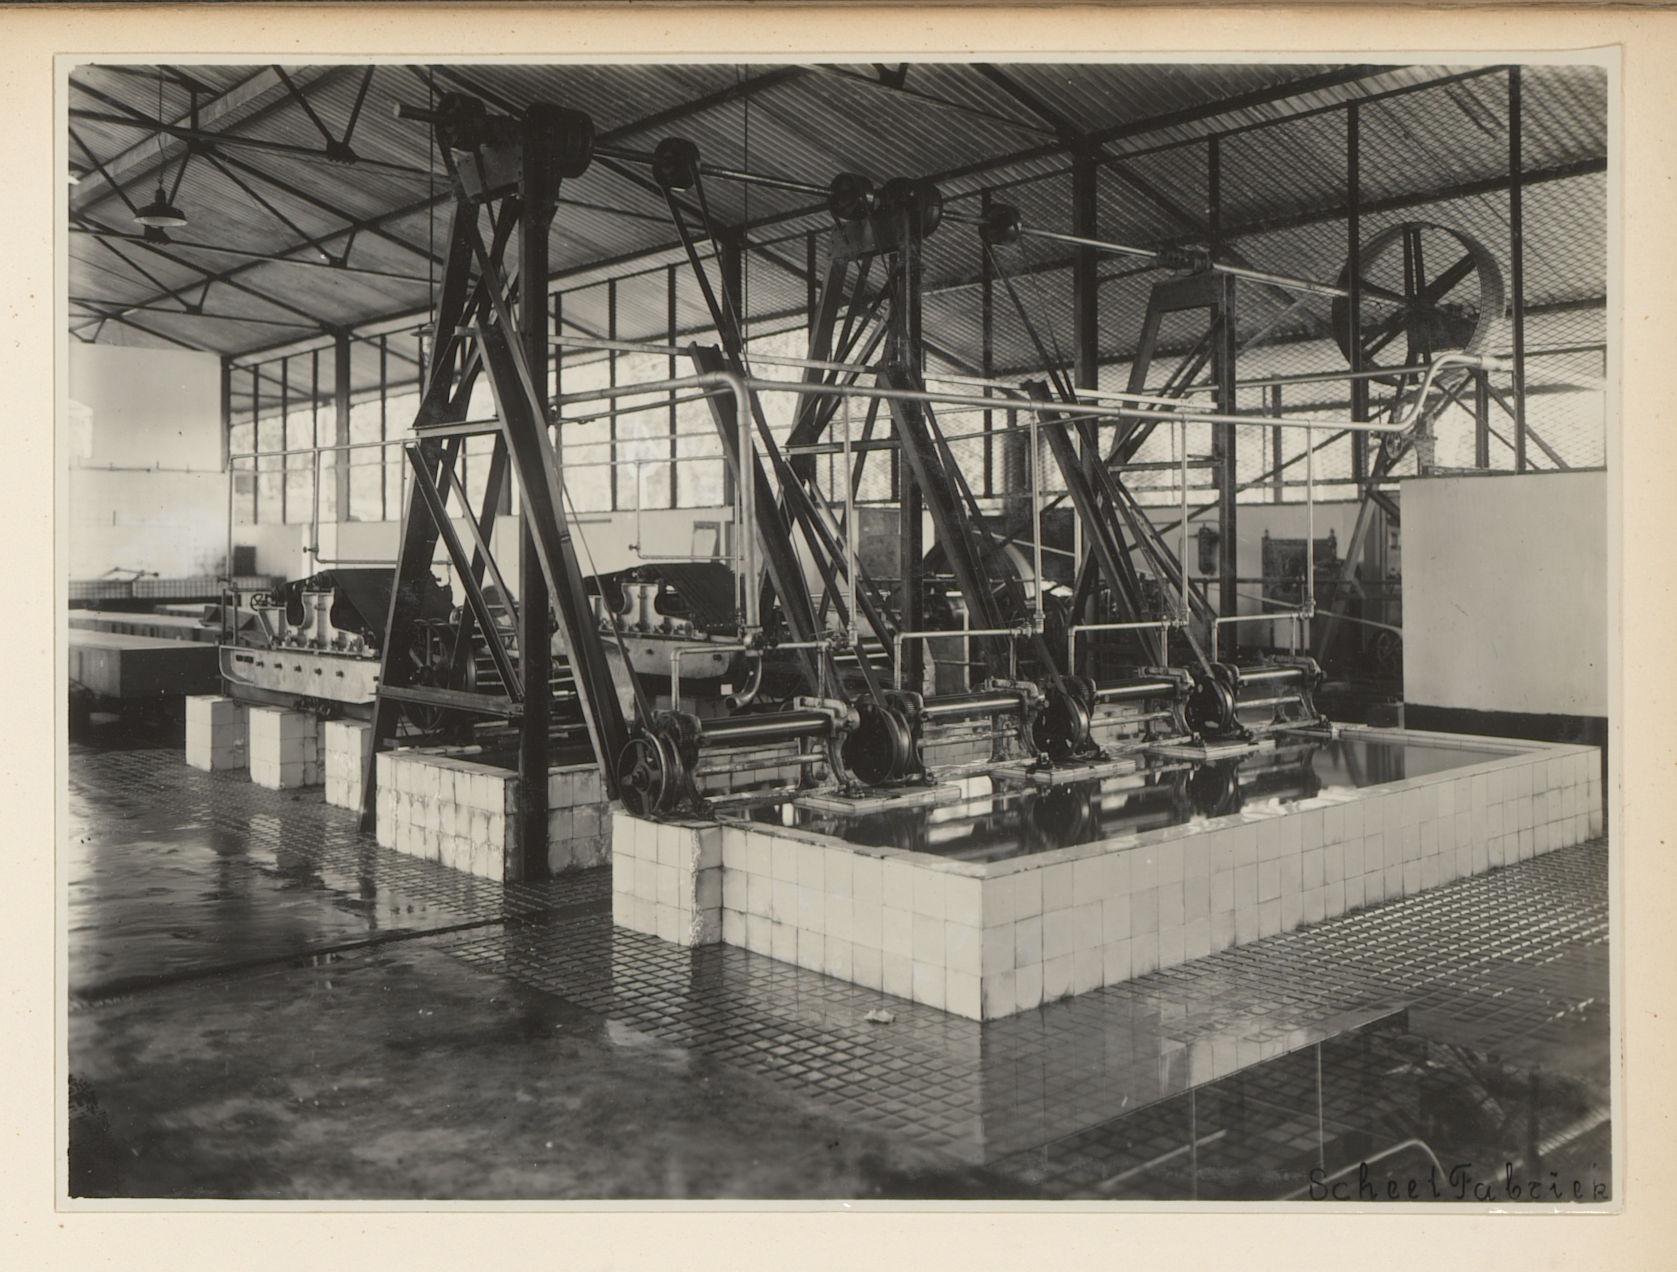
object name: photograph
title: Sheetfabriek Pernantian (1932)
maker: Anonymous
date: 1932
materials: photographic support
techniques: gelatin silver print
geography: sumatra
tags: plantation, (non-fruit) products of plants or trees: rubber, interior of industrial structures (regardless of the materials processed or the products made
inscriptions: inscription: ‘Sheet Fabriek’, inscription: ‘Sheetfabriek Pernantian (1932)’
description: Fabriekshal van de Sheetfabriek van Sucama Pernantian. Met opschrift op de foto geschreven. Onderdeel van het fotoalbum over de plantages Brussel en Pernantian van de Sumatra Caoutchouc Maatschappij op de Oostkust van Sumatra in de jaren 1910-1935.